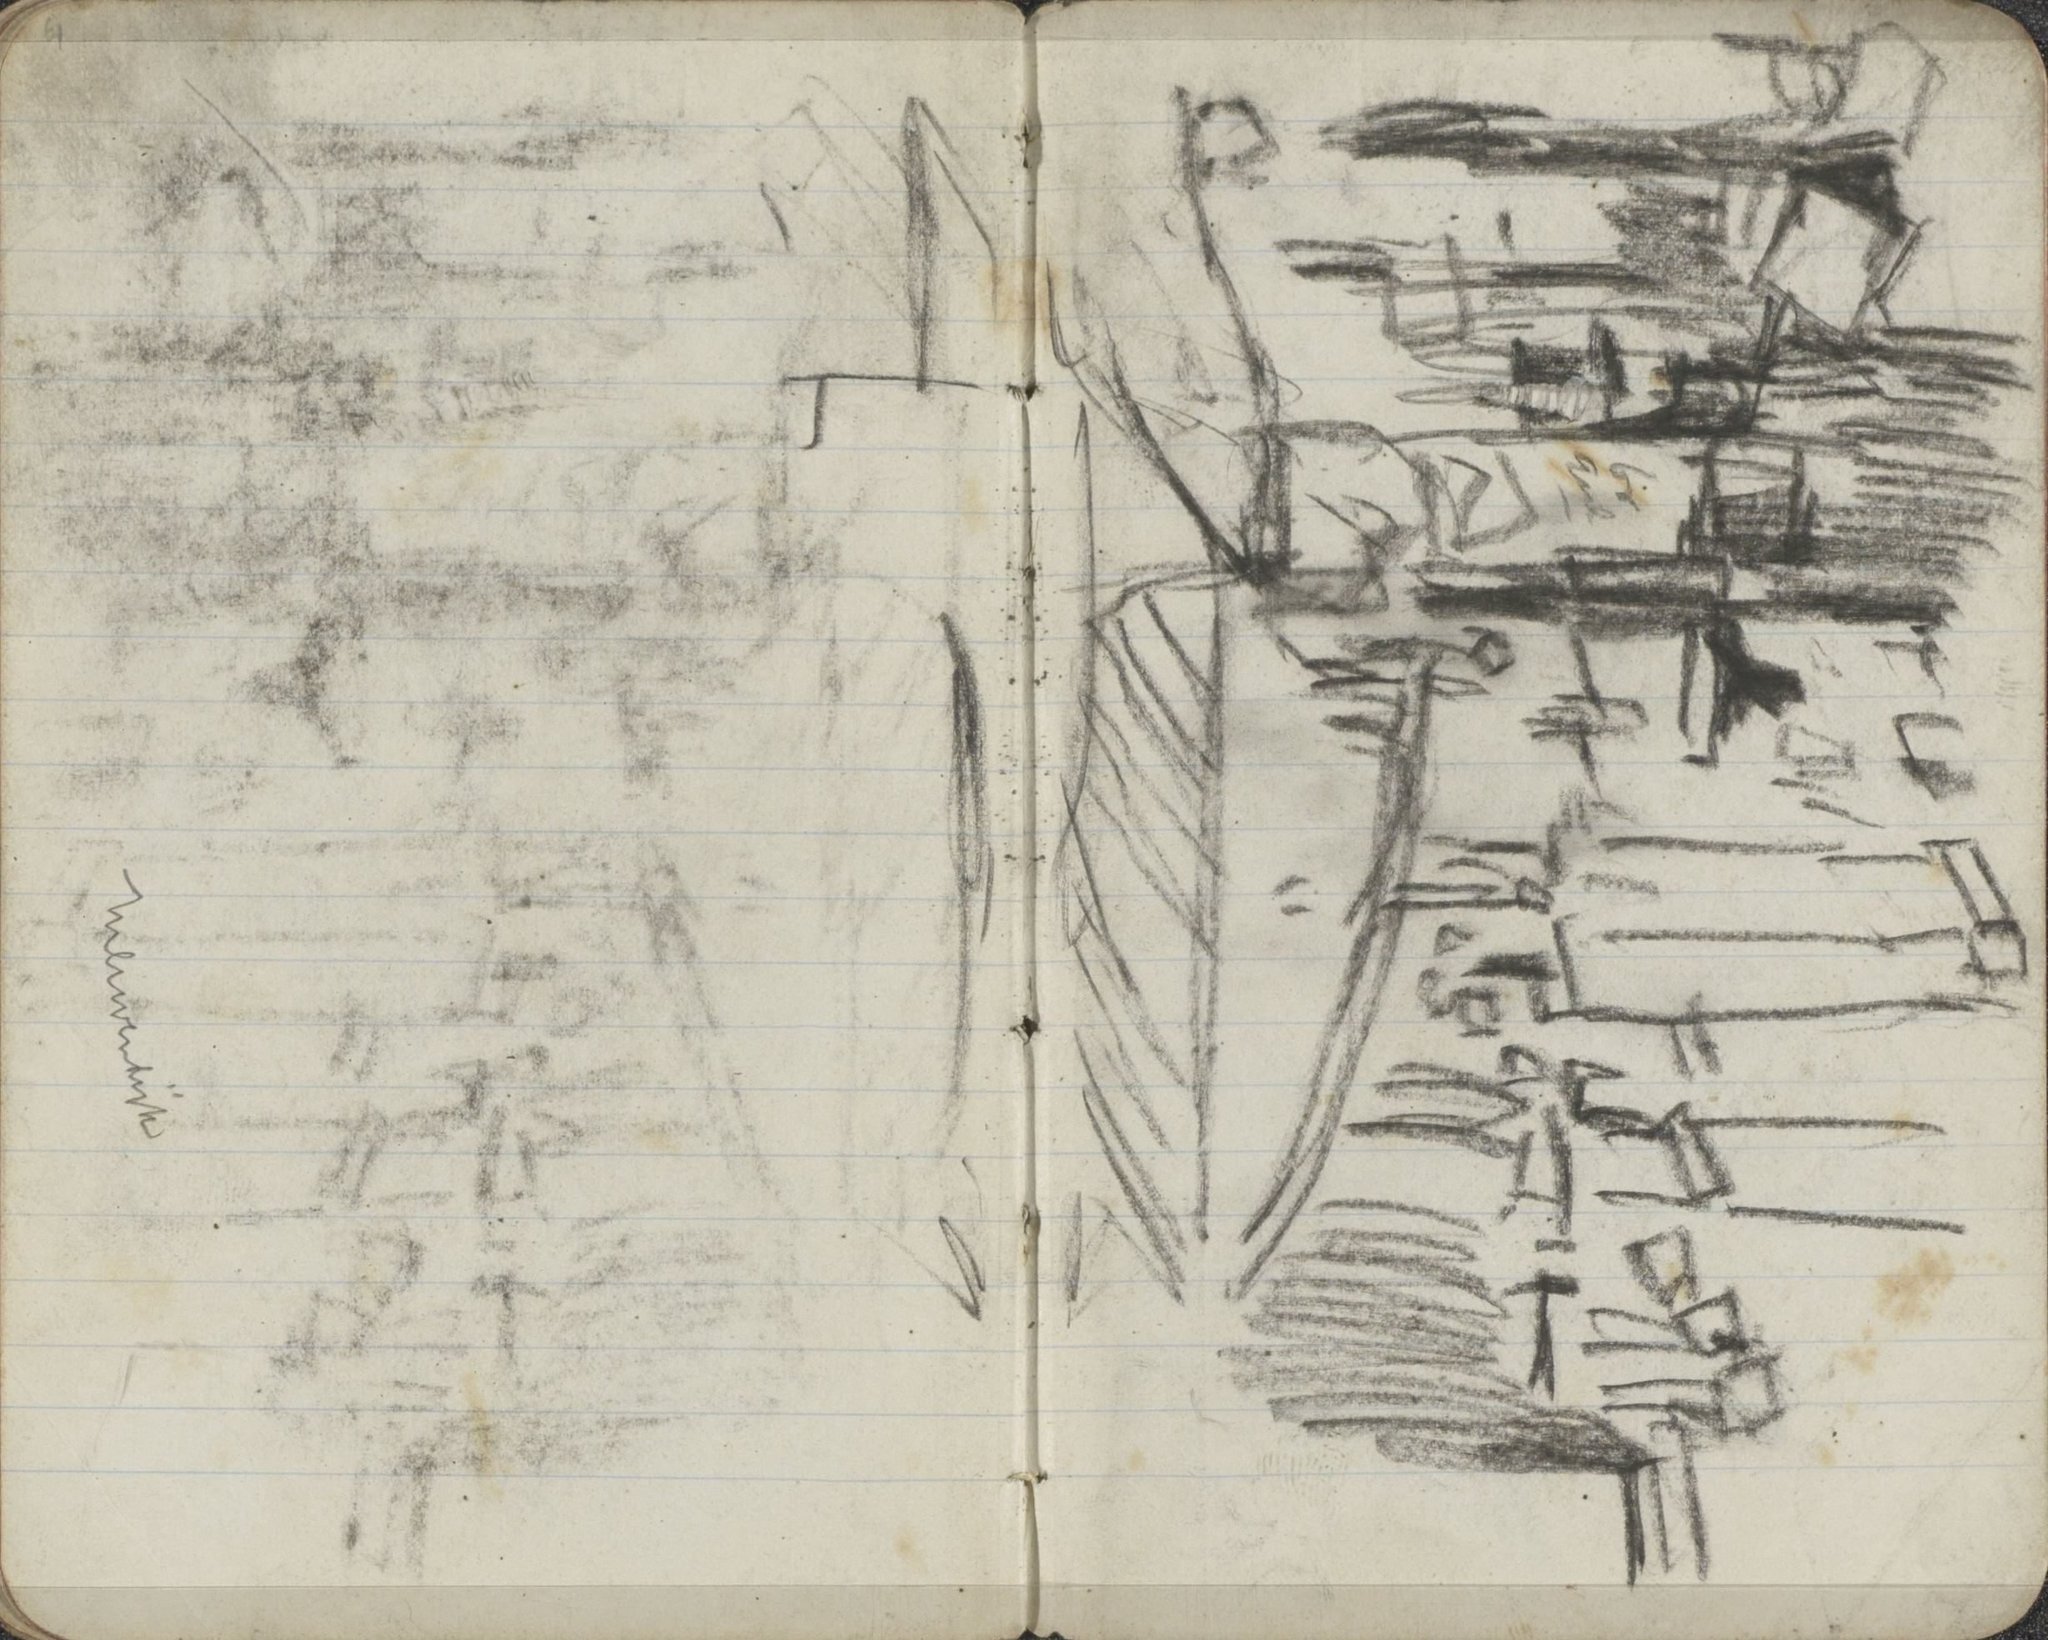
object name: sketchbook leaf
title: Gezicht op de Nieuwendijk te Amsterdam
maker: george hendrik breitner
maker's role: draughtsman, painter, print maker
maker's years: 1857-1923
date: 1894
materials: chalk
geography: amsterdam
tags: shop, store, civic architecture; edifices; dwellings, street (+ city(-scape) with figures, staffage)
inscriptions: annotation: ‘Nieuwendijk’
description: Pagina 61 en pagina 62 uit een schetsboek met 31 bladen.